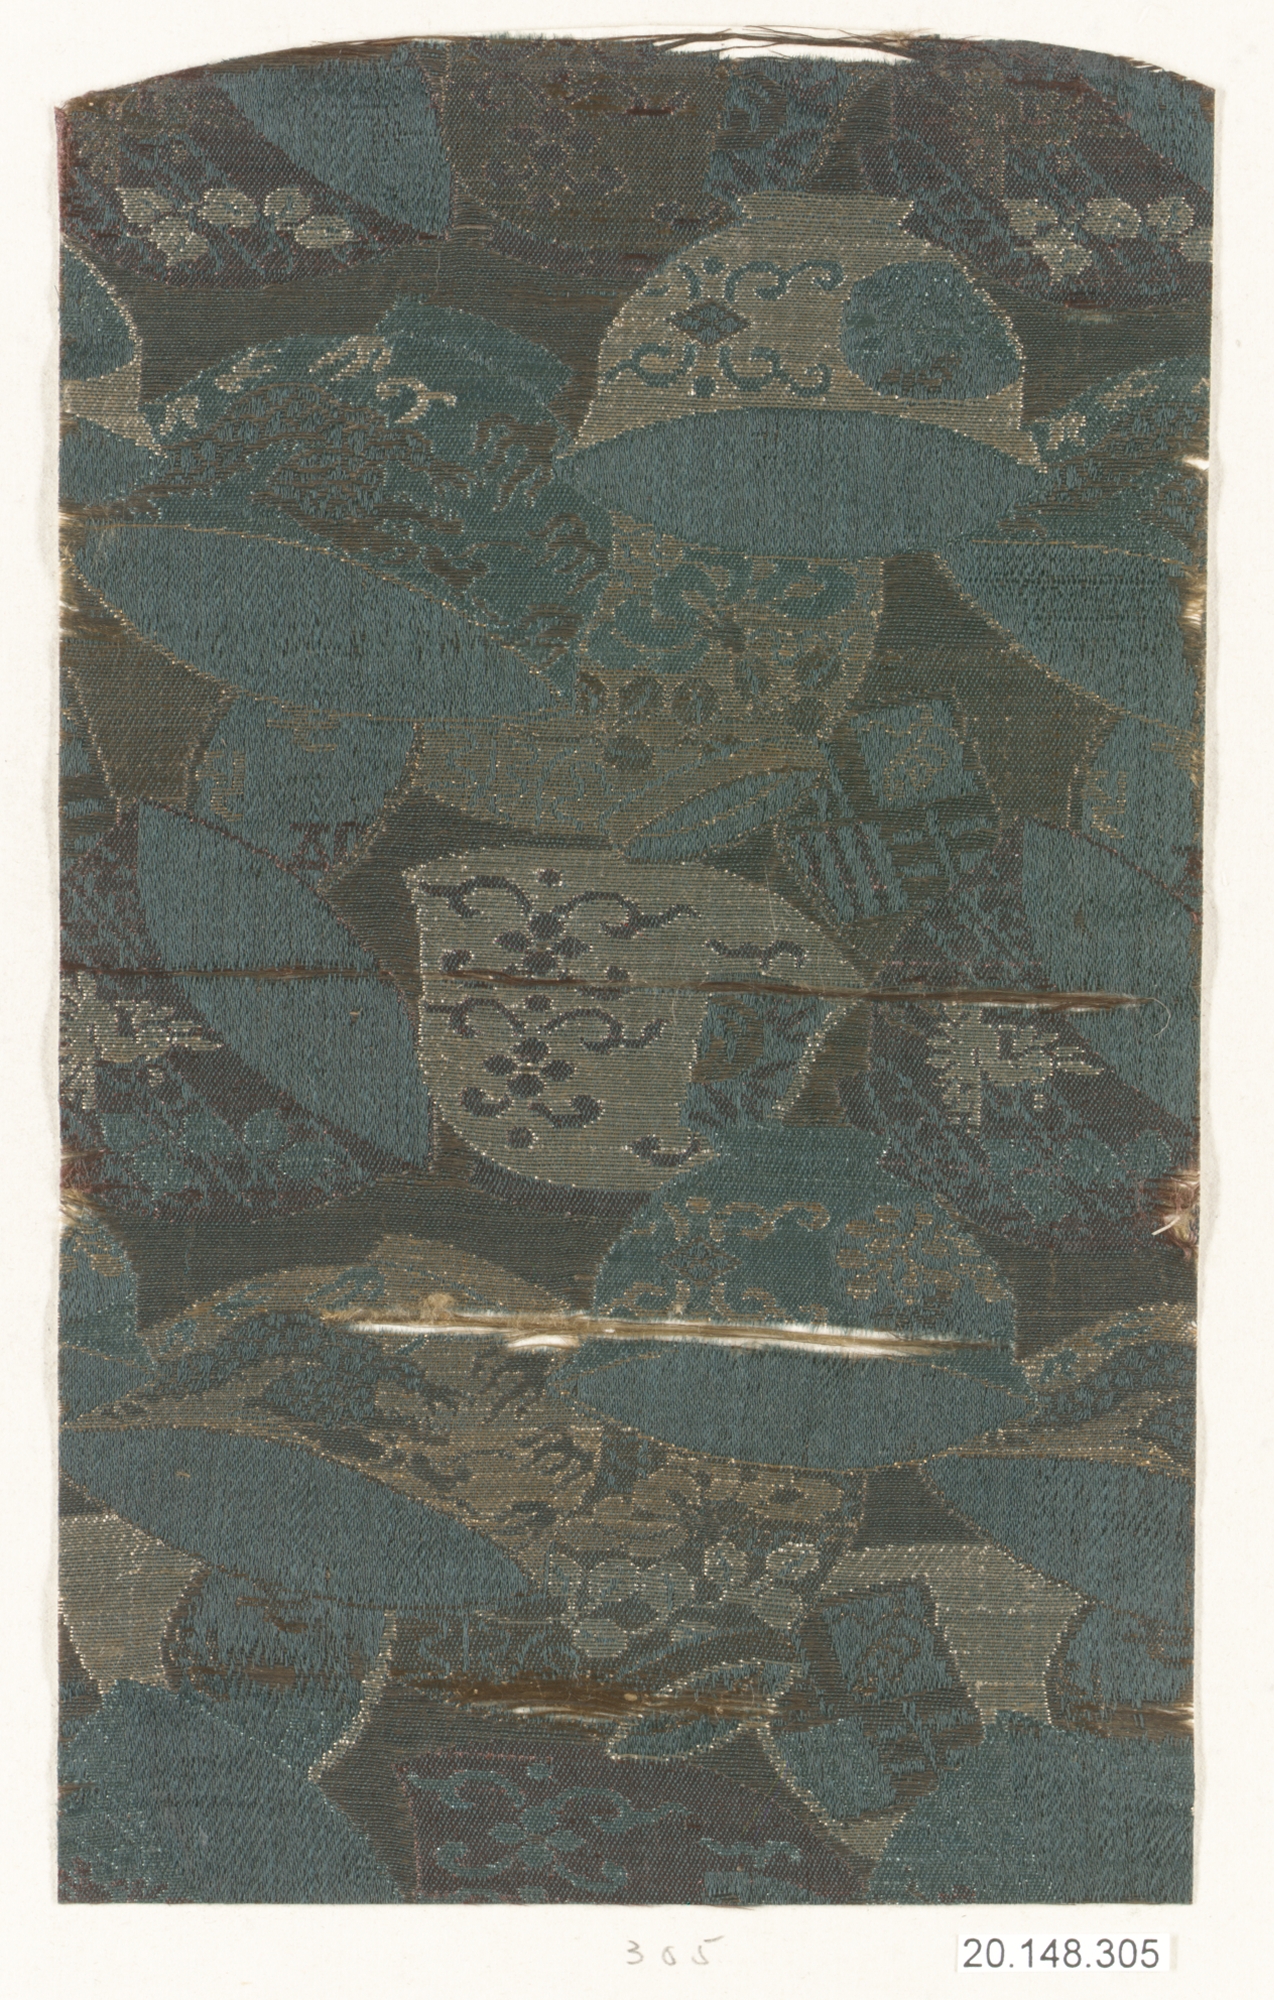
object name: piece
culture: japanese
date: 1701-1800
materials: silk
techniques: compound weave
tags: leaves